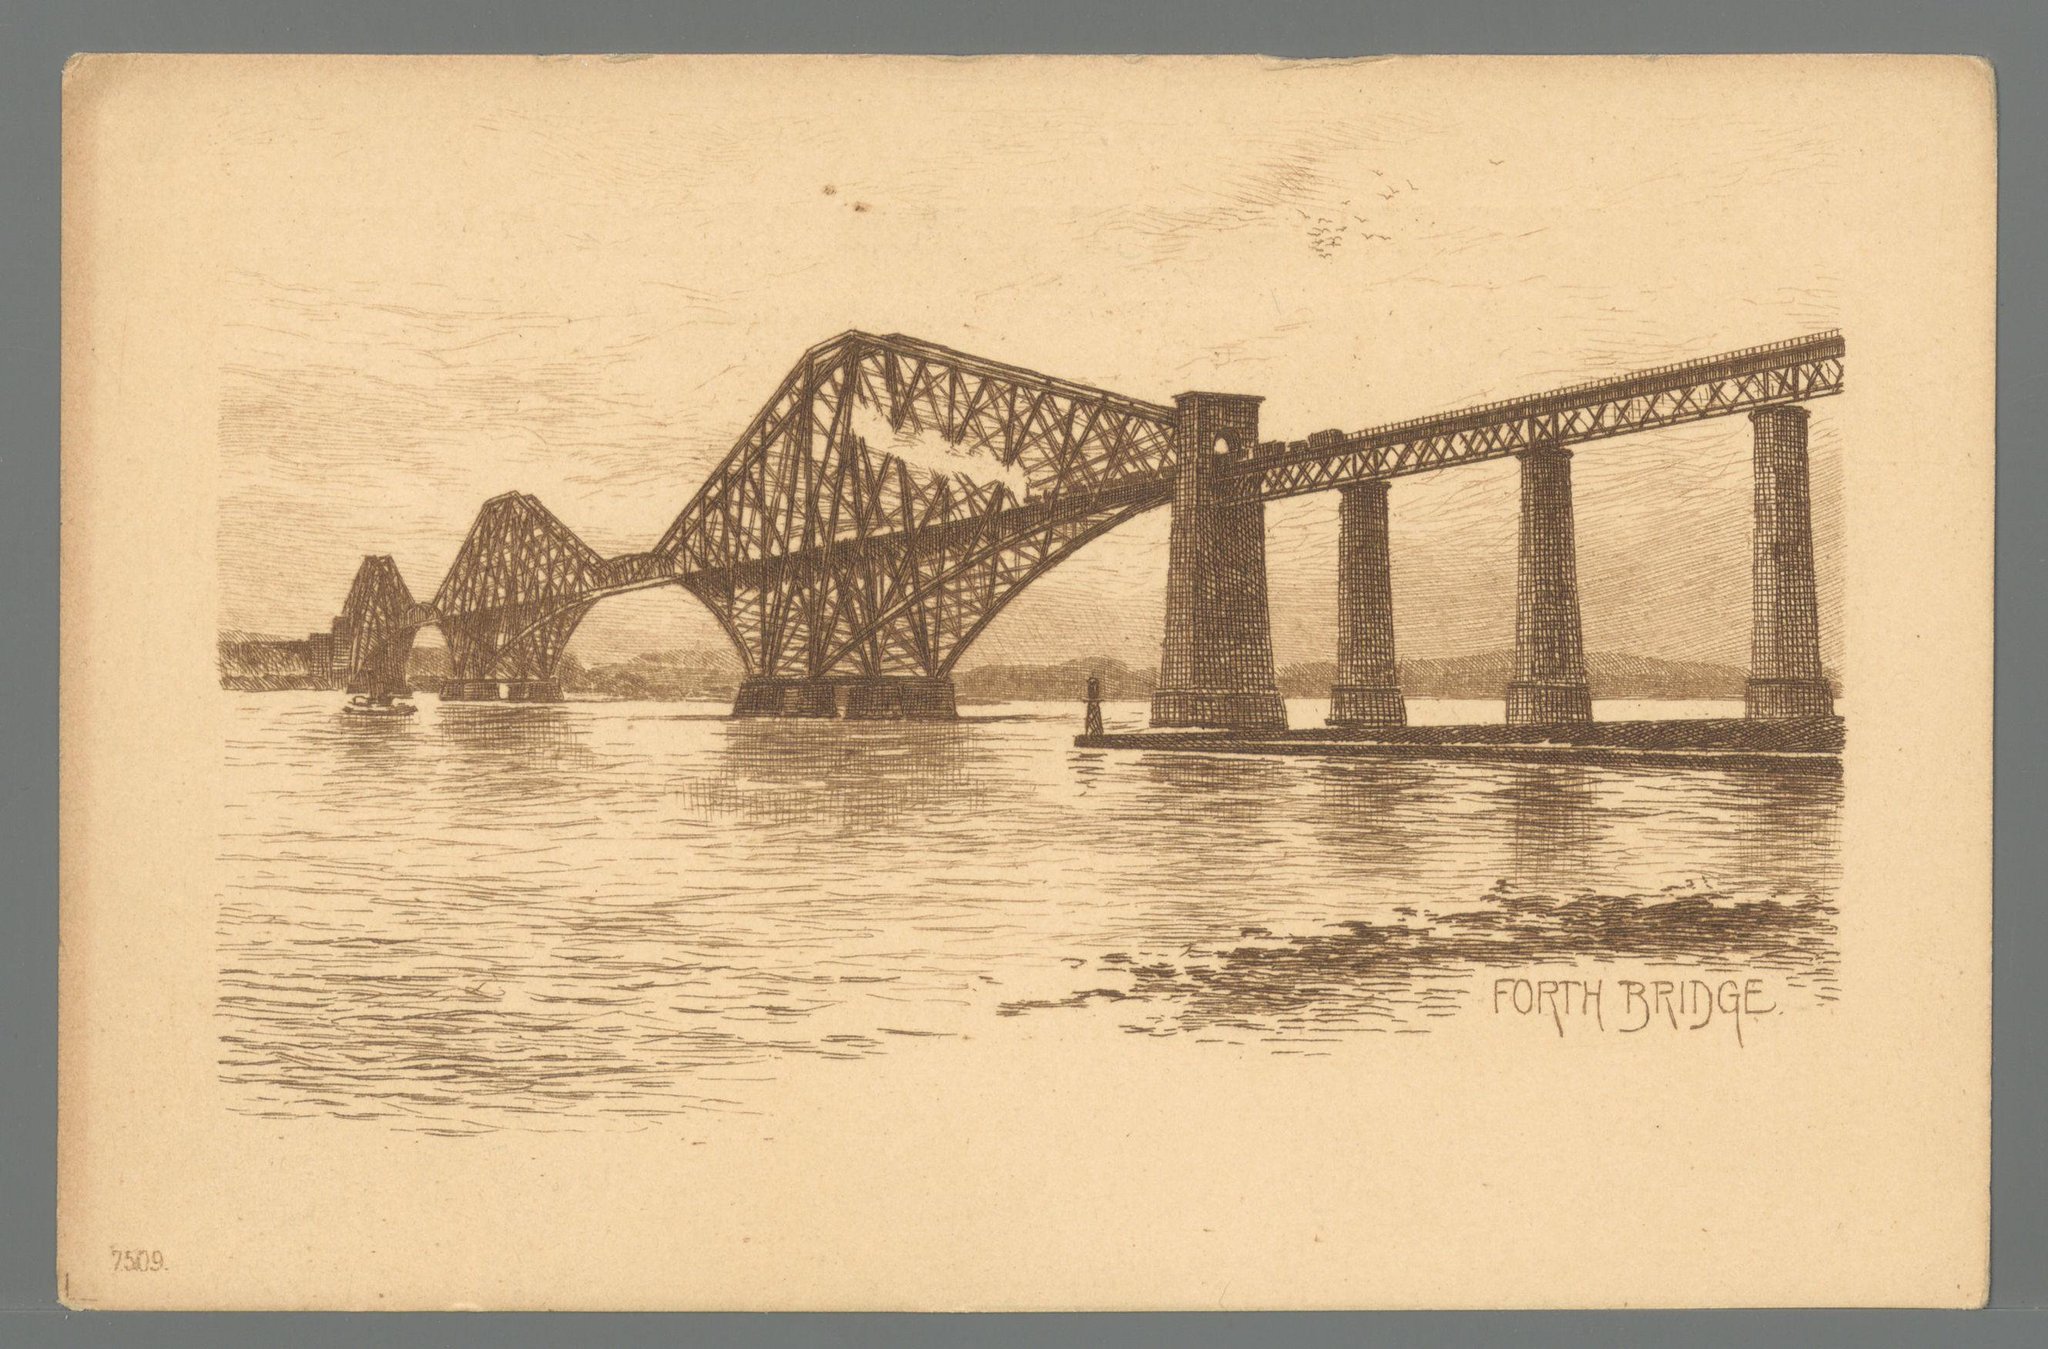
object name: ansichtkaart, prentbriefkaart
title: Forth Bridge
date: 1894-1905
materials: cardboard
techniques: etching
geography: glasgow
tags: bridge in city across river, canal, etc., sea